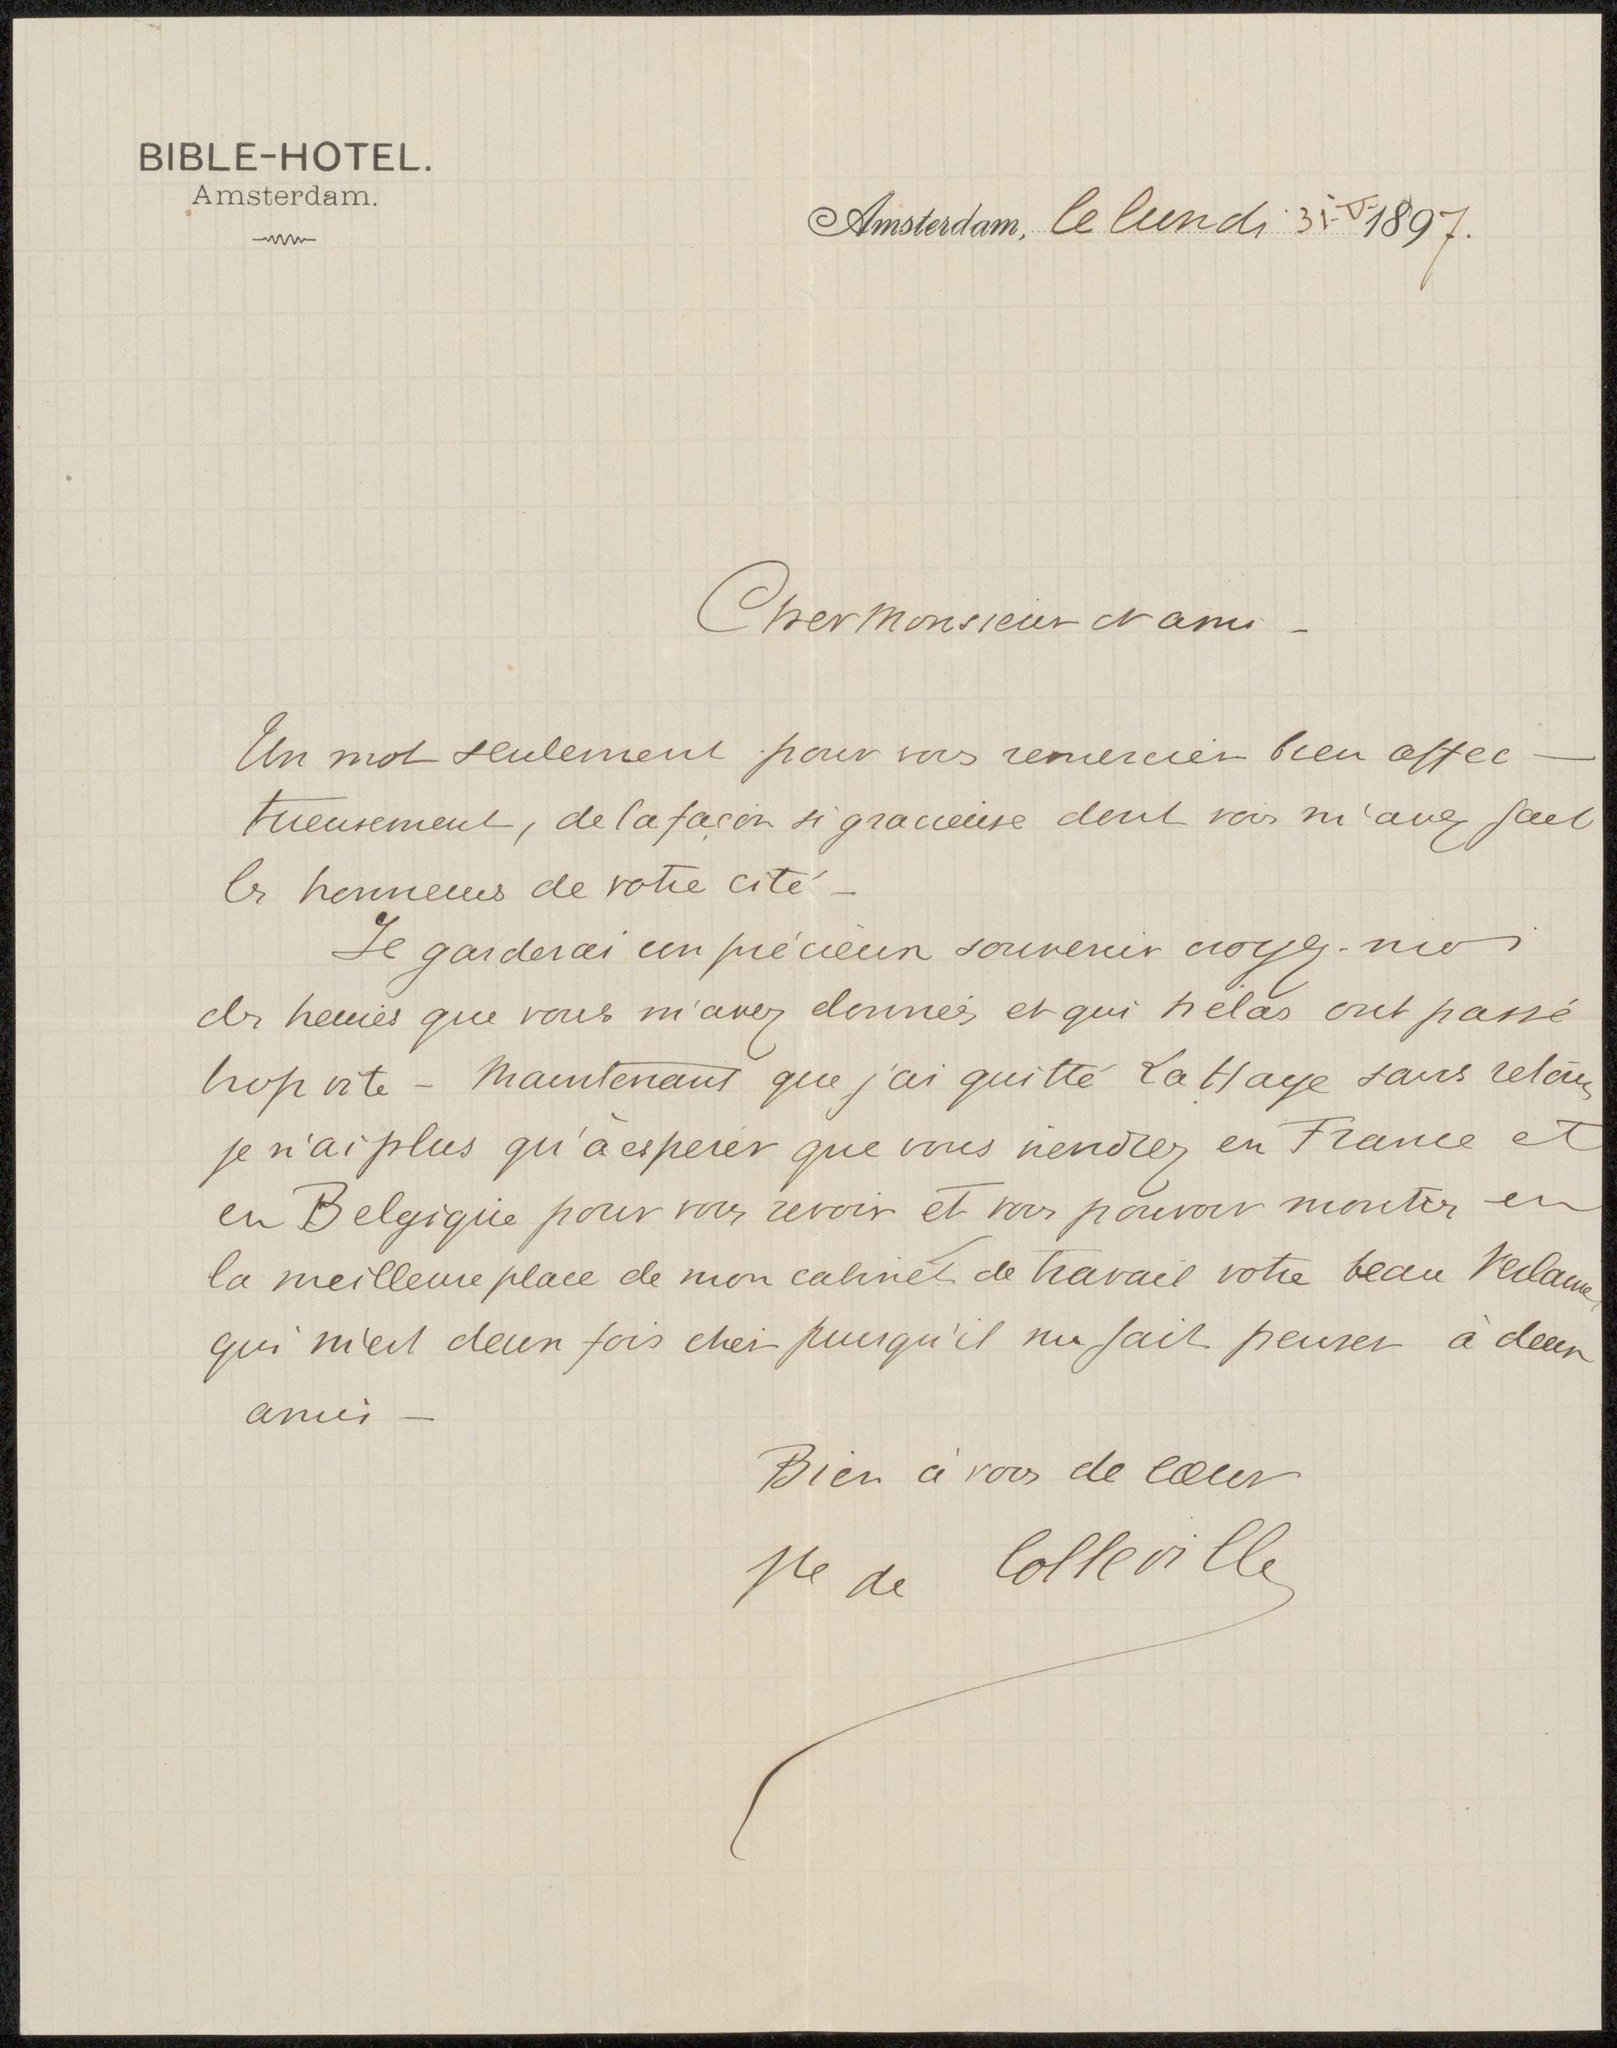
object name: letter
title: Brief aan Philip Zilcken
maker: burggraaf de colleville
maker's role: burggraaf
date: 1897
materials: ink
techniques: pen, printing, writing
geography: amsterdam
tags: paris, paul verlaine, painter, draughtsman, philip zilcken, the hague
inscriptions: collector's mark: ‘RPK’